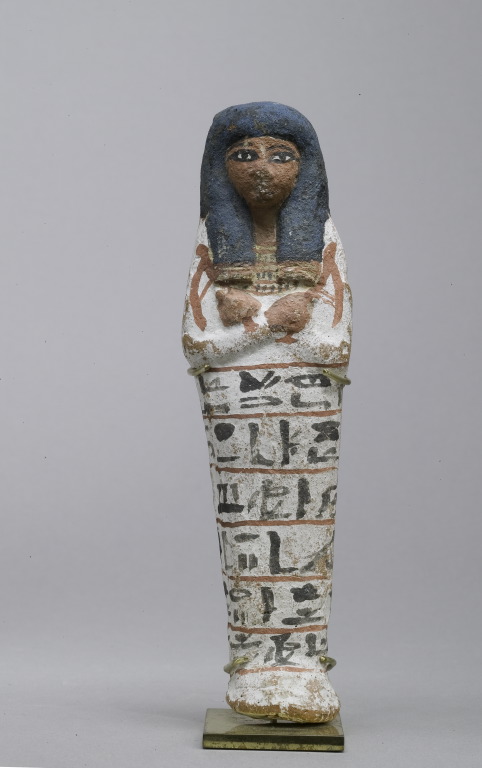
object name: shabti, khabekhnet, sennedjem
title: Shabti of Khabekhnet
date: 1279-1213 BCE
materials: paint, pottery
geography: egypt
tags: hieroglyphs